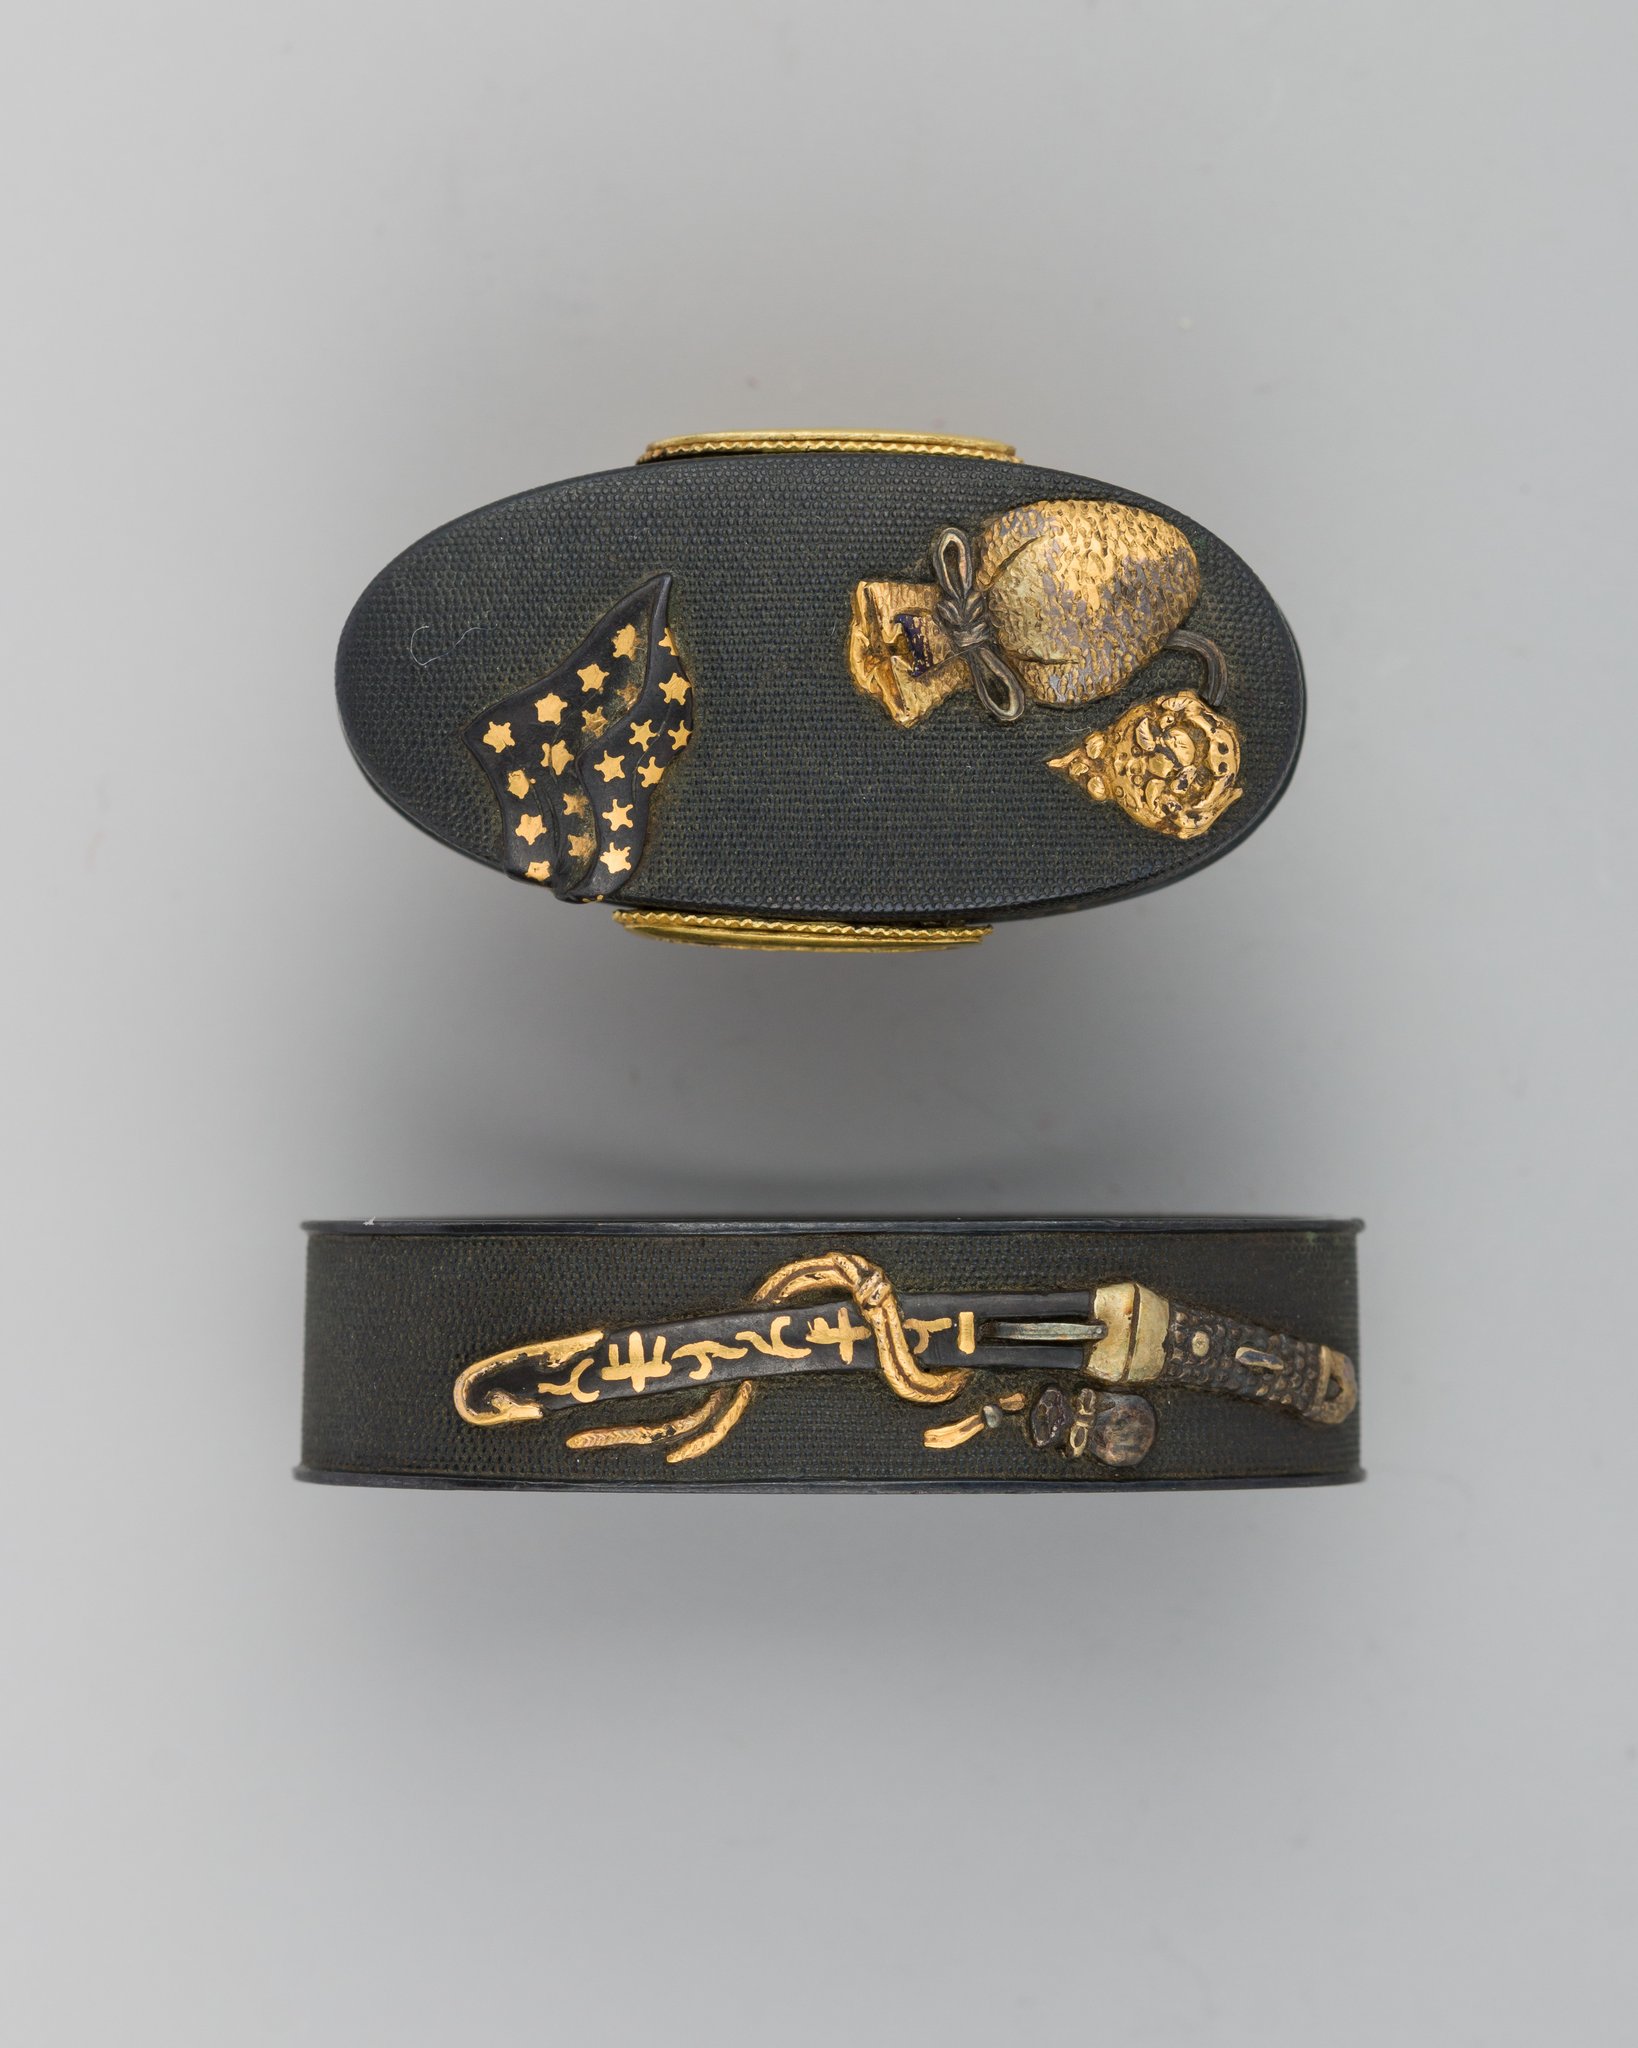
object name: sword hilt collar and pommel fuchigashira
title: Sword-Hilt Collar and Pommel (Fuchigashira)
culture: japanese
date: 1751-1800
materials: gold alloy, silver alloy, gold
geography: japan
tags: swords